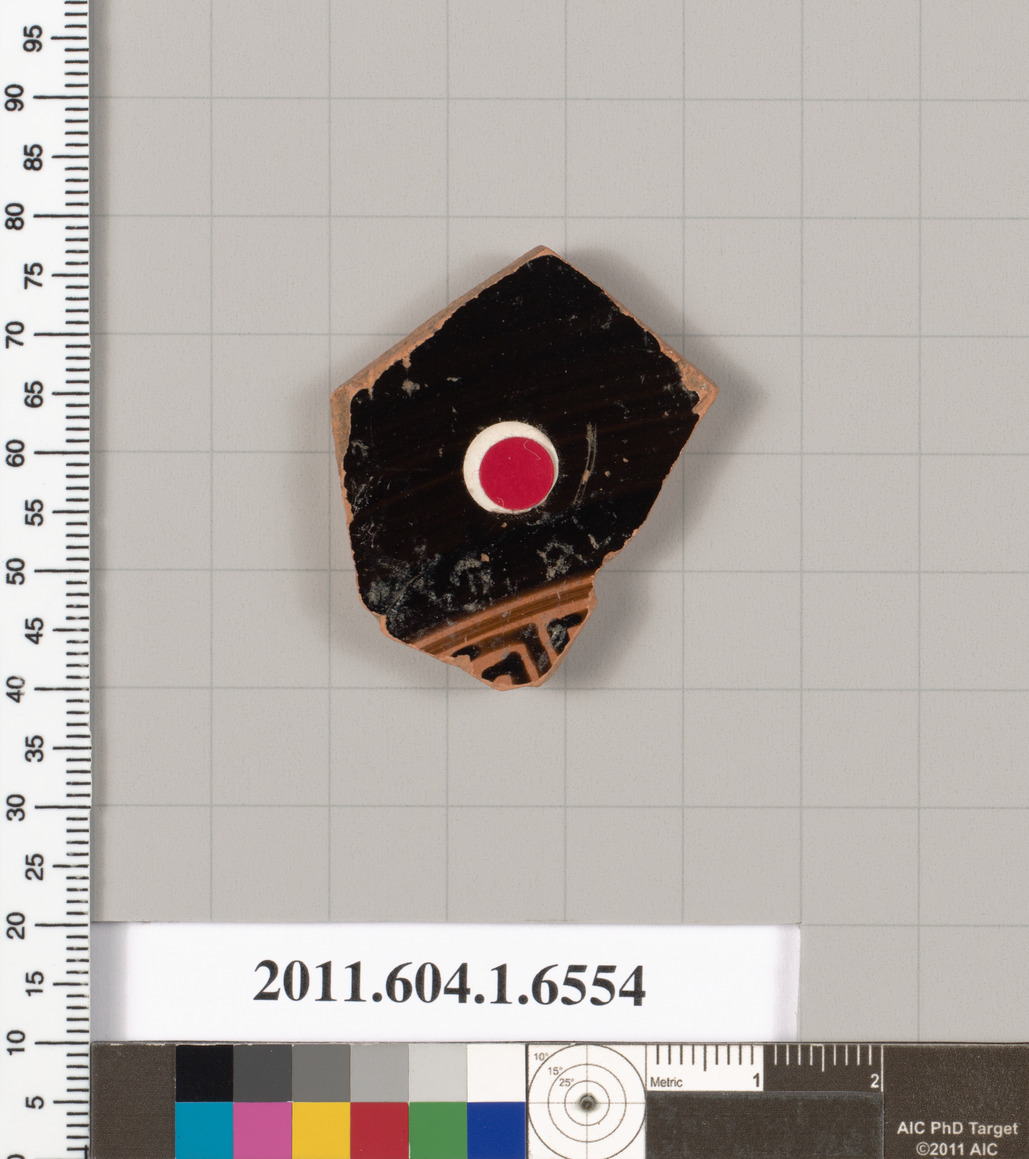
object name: kylix fragment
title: Terracotta fragment of a kylix (drinking cup)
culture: greek, attic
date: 490-480 BCE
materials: terracotta